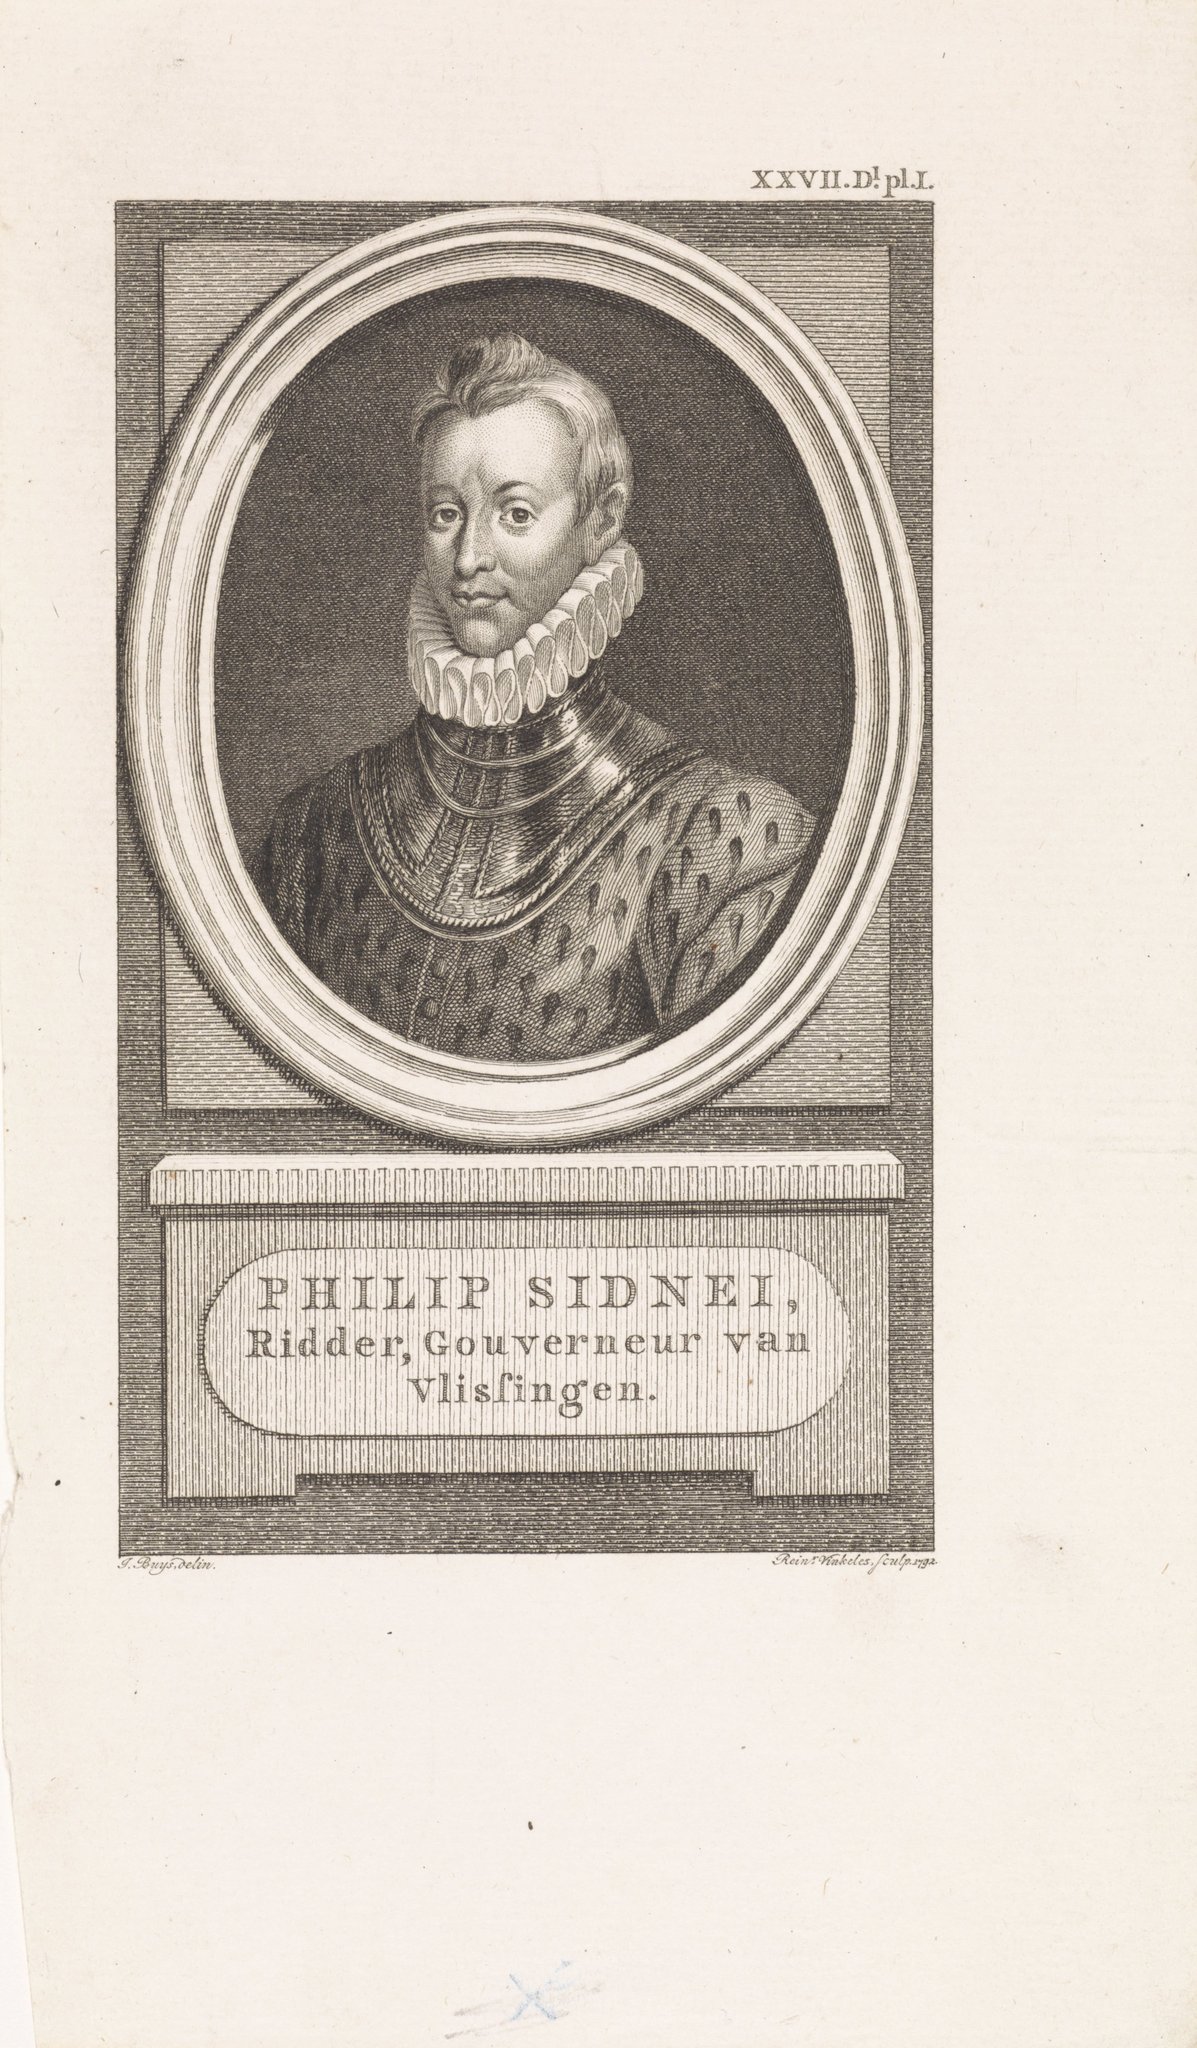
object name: book illustration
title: Portret van Philip Sidney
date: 1792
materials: paper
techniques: engraving, etching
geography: amsterdam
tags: dichter, diplomaat, philip sidney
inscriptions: collector's mark: Lugt 2228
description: Prent gebruikt als boekillustratie in: Kok, Jacobus. Vaderlandsch woordenboek : met kaarten, plaaten en pourtraitten. Amsterdam: Johannes Allart, 1785-1796. Deel XXVII.